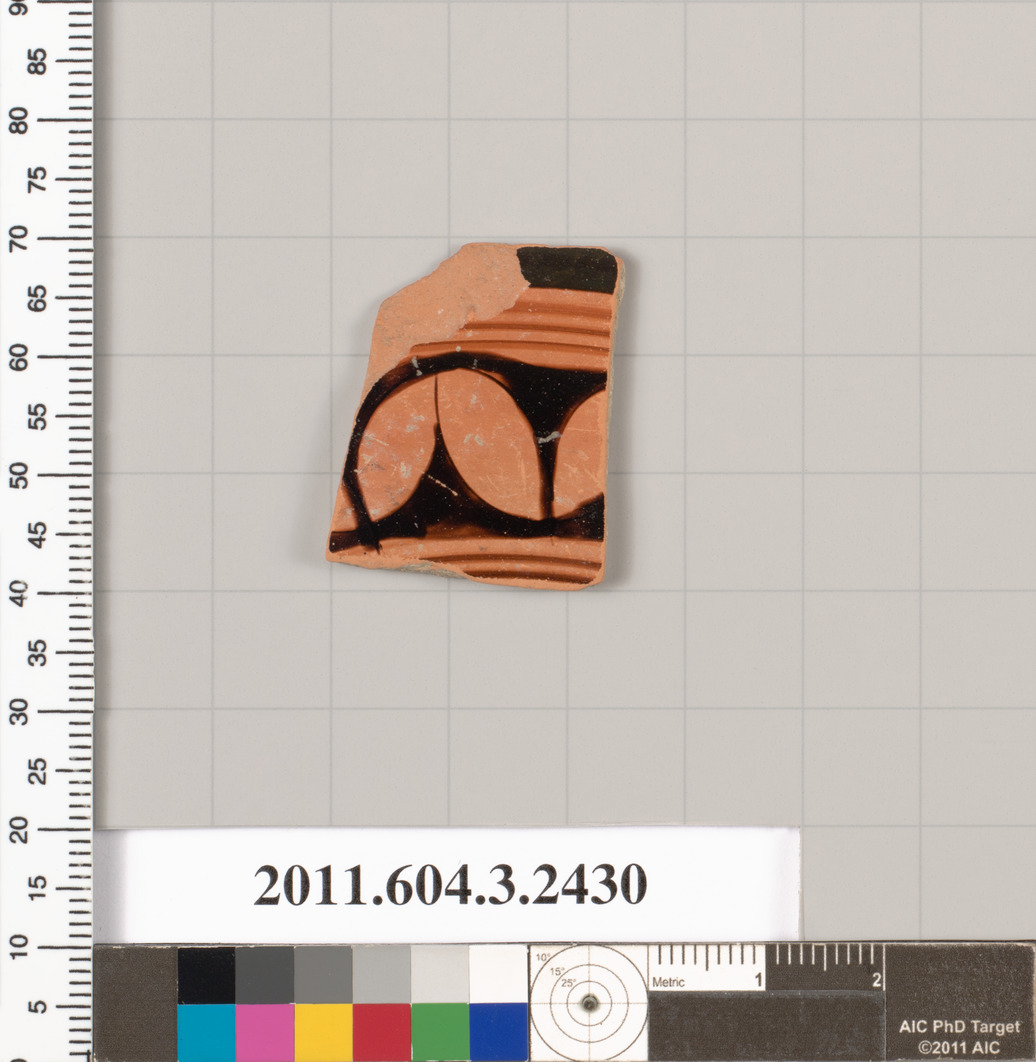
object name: kylix fragment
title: Terracotta fragment of a kylix (drinking cup)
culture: greek, attic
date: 525-501 BCE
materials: terracotta